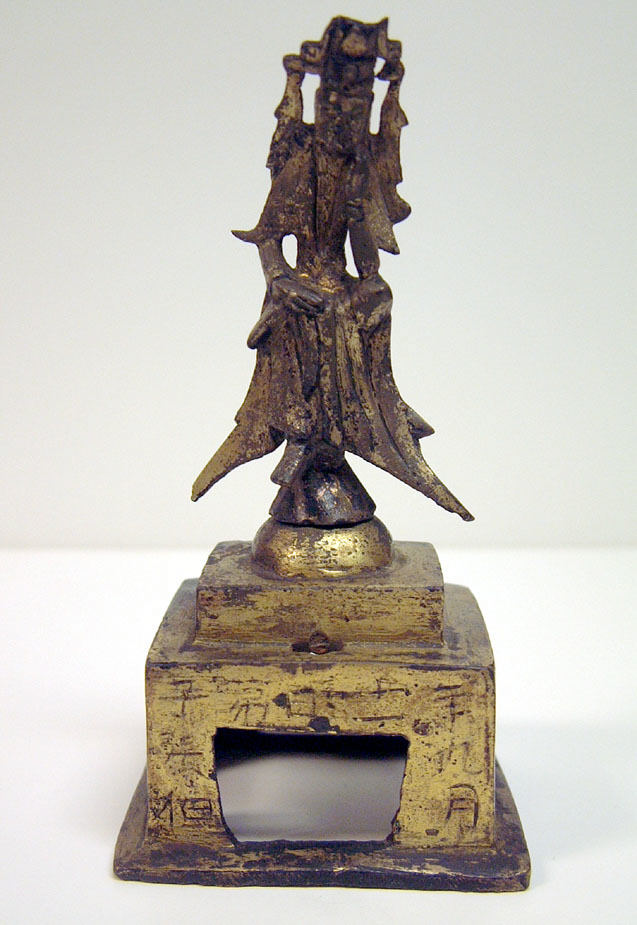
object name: statuette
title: Seated Buddha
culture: chinese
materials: gilt bronze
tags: buddha